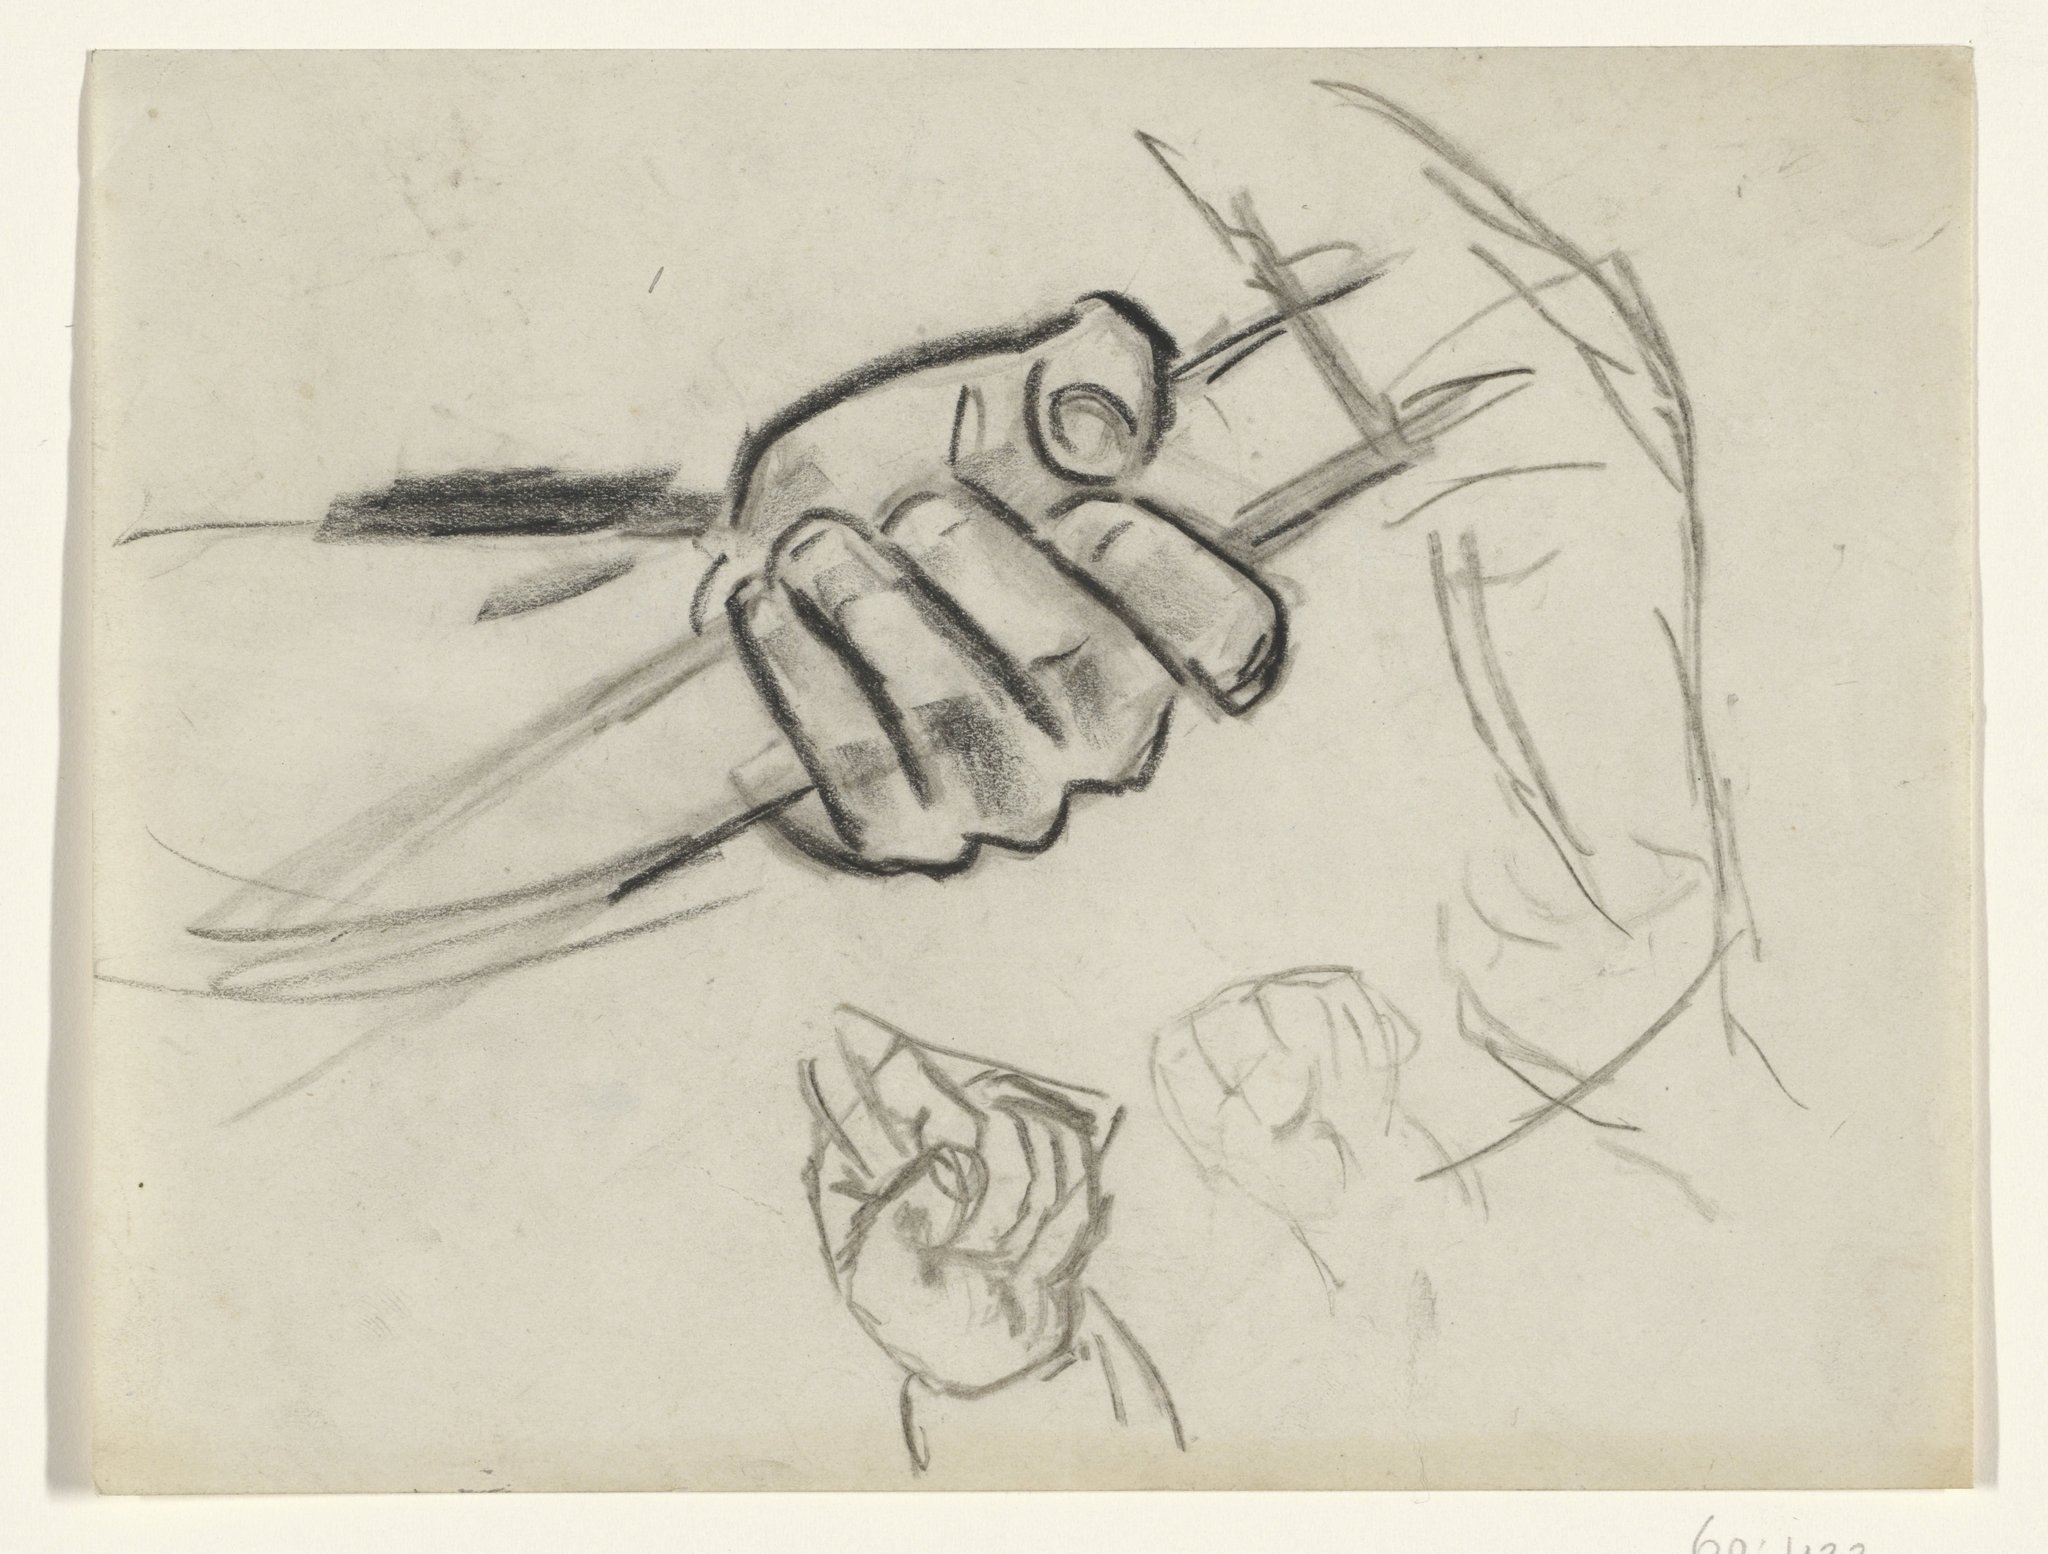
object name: drawing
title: Vuisten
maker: leo gestel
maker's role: draughtsman, print maker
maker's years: 1881-1941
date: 1891-1941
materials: chalk, paper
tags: hand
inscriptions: collector's mark: Lugt 2228